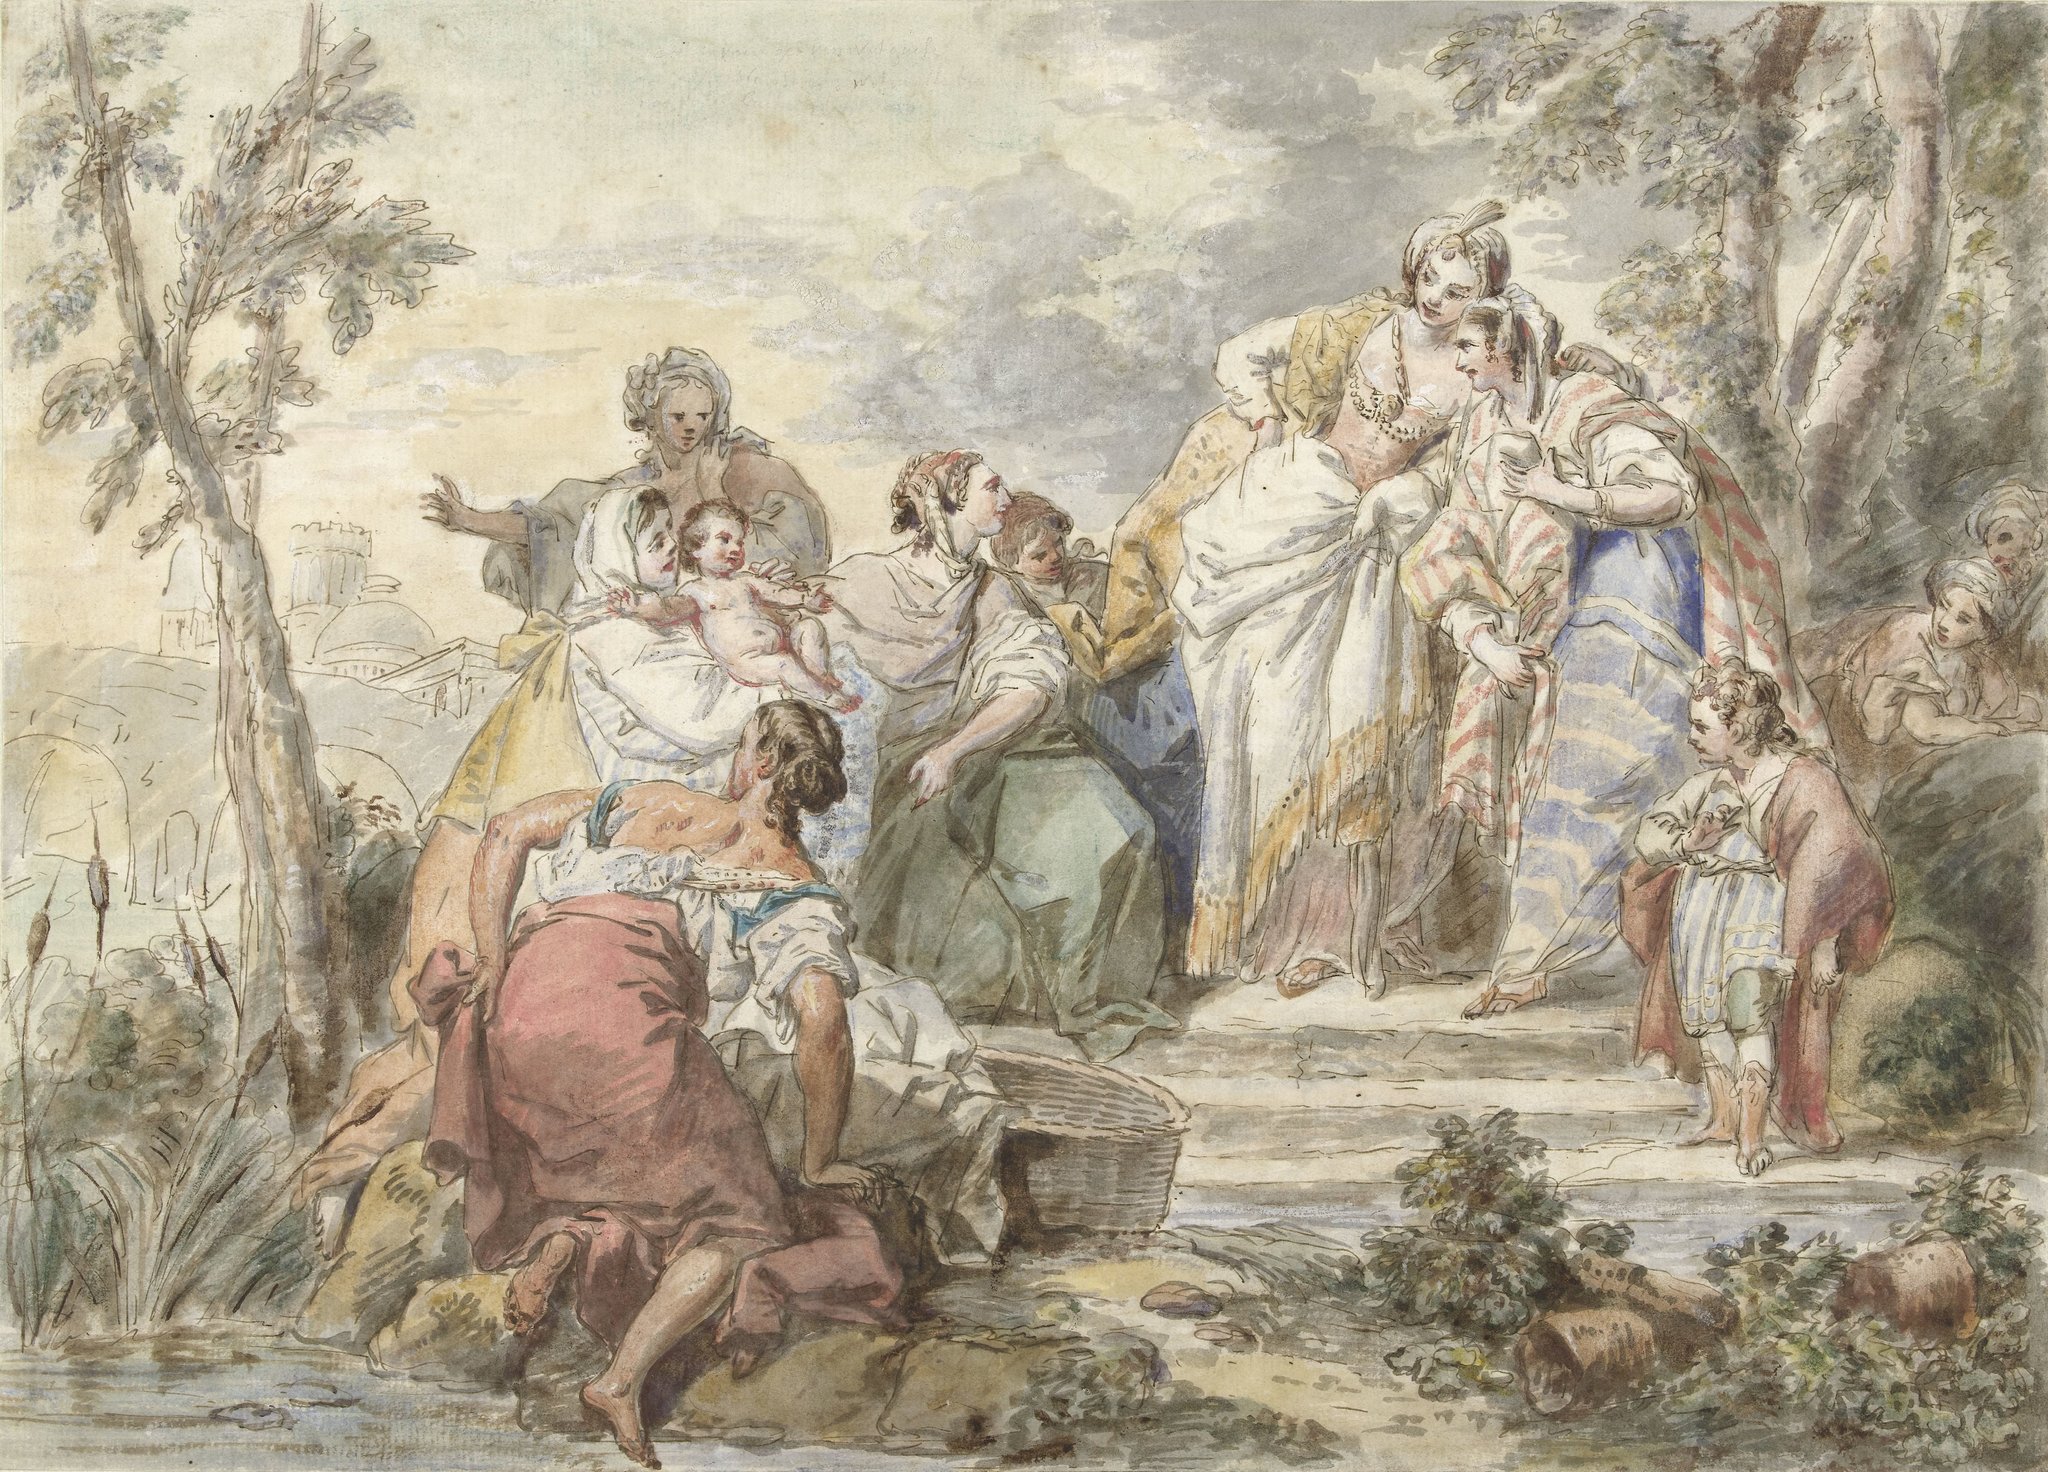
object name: watercolor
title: De vinding van Mozes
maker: jean baptist leprince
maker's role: draughtsman, print maker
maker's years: 1734-1781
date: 1744-1781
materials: ink, paper, watercolor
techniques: brush, pen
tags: the finding of moses: pharaoh's daughter comes to bathe with her maidens in the river and discovers the child floating on the water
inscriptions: annotation, verso, lower left, pencil: ‘55-’, collector's mark: Lugt 2228